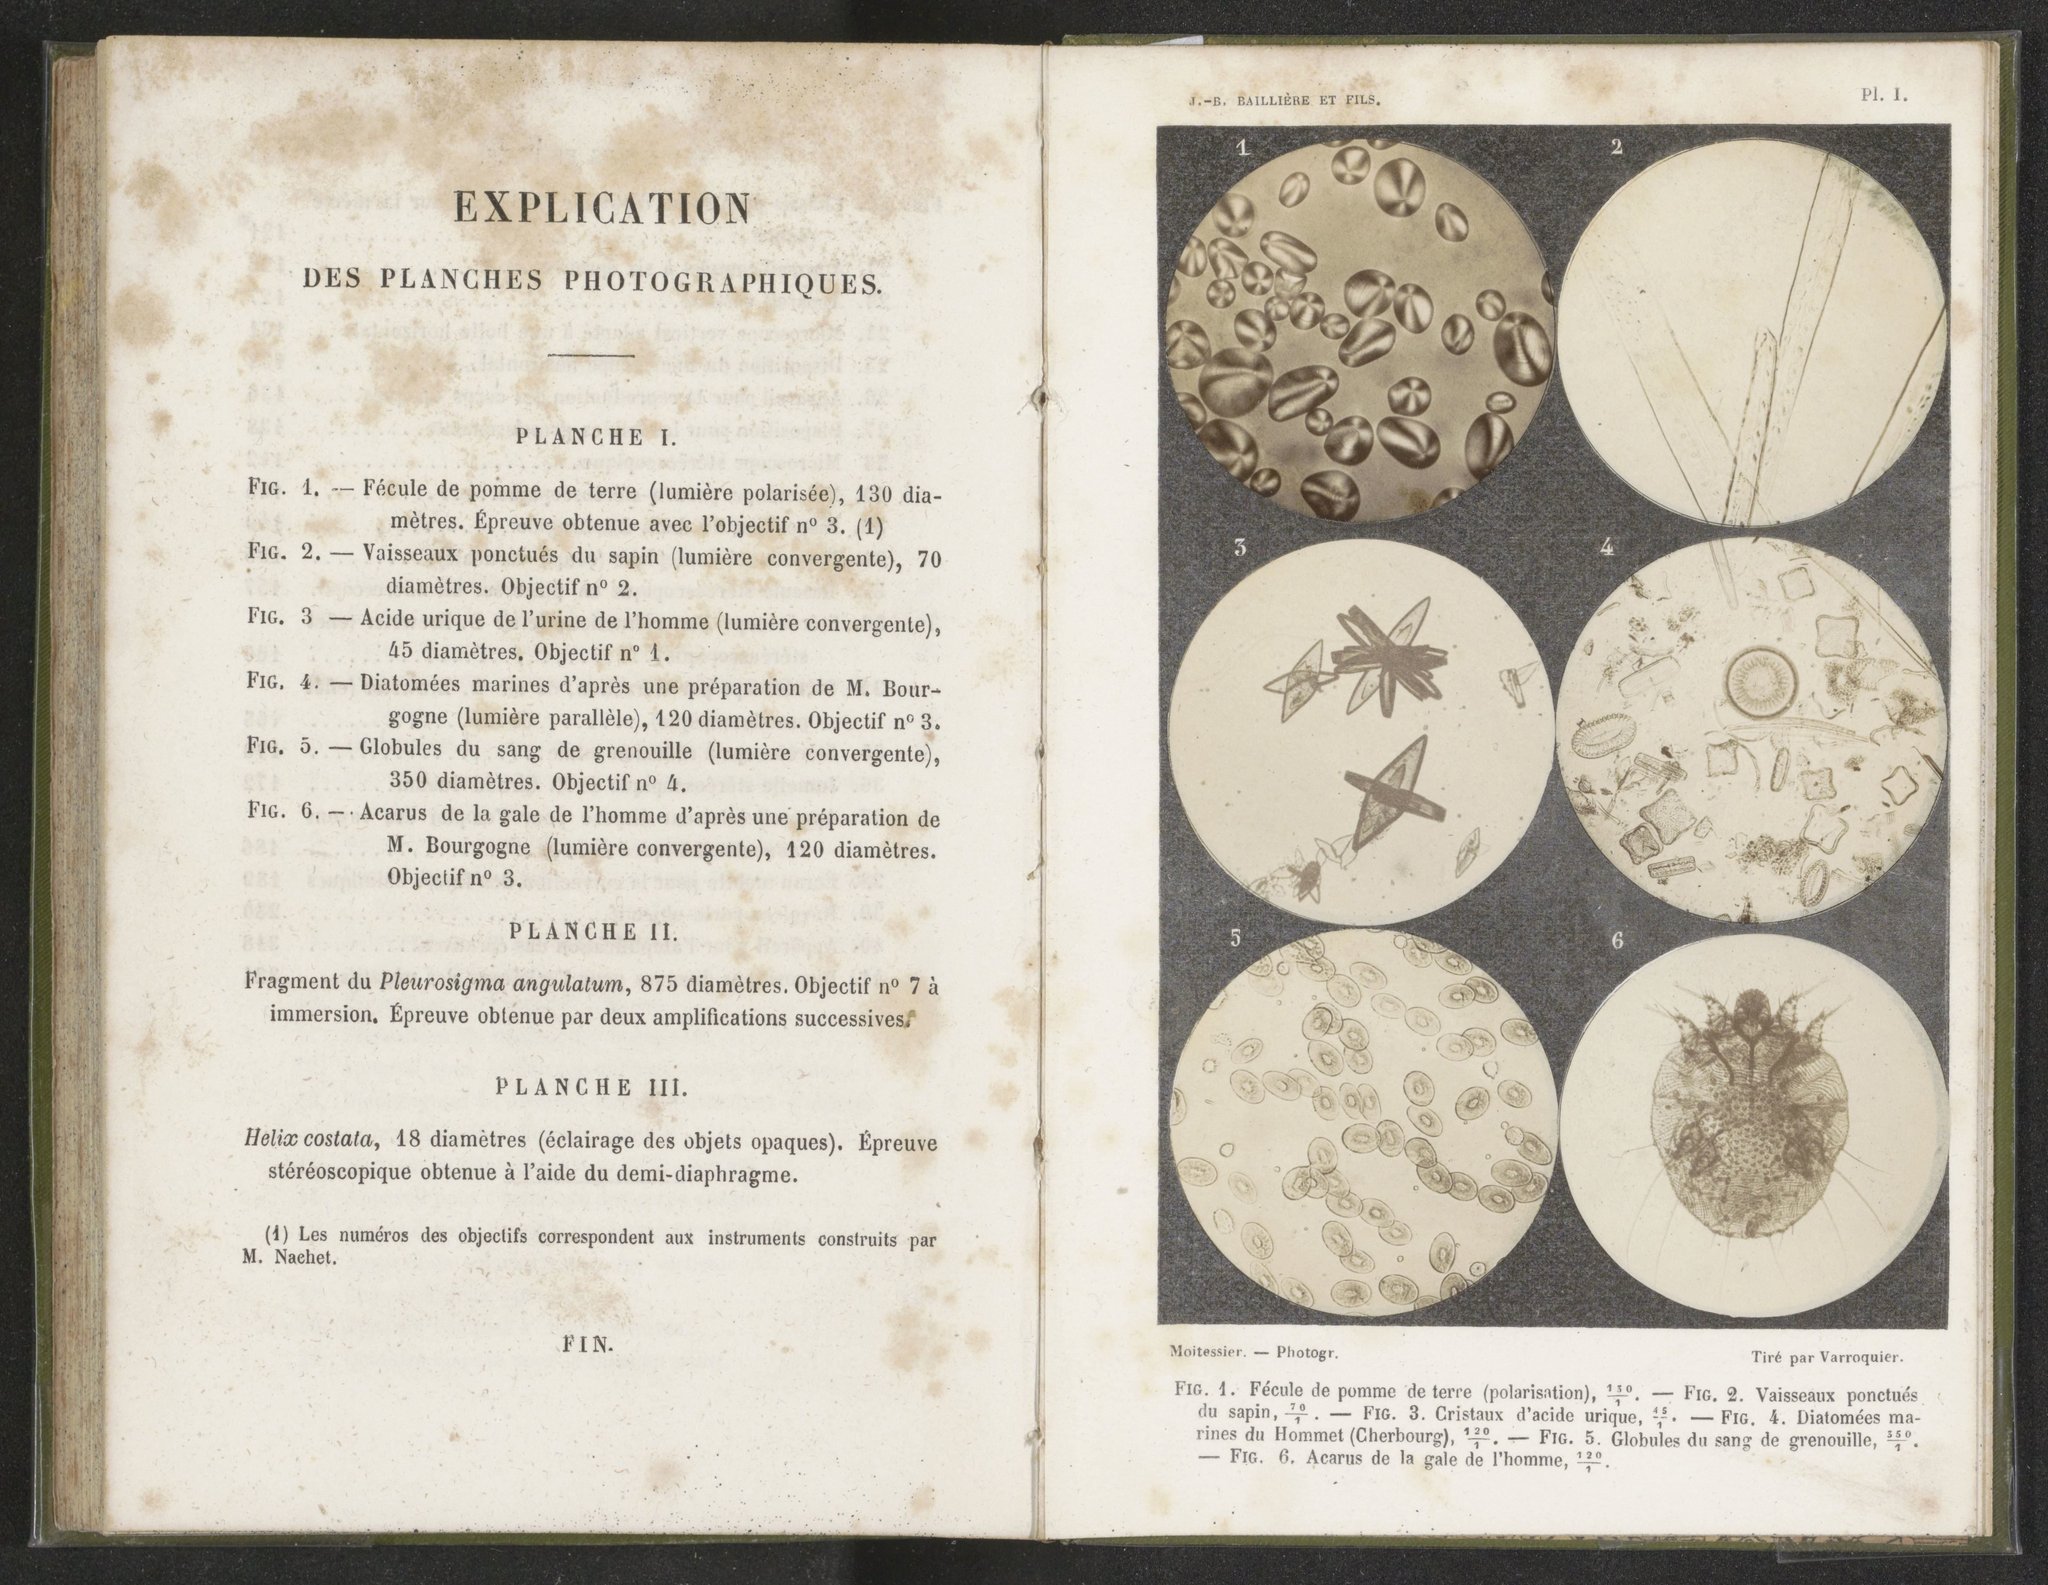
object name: page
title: Zes micro-opnamen van cellen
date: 1856-1866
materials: photographic support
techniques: albumen print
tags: microscope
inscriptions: number: ‘Pl. I.’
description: Nummers 1 tot en met 6: aardappelzetmeel, dennennaald, urinezuurkristallen, kiezelwieren, bloedcellen van een kikker, mijt van menselijke schurft.